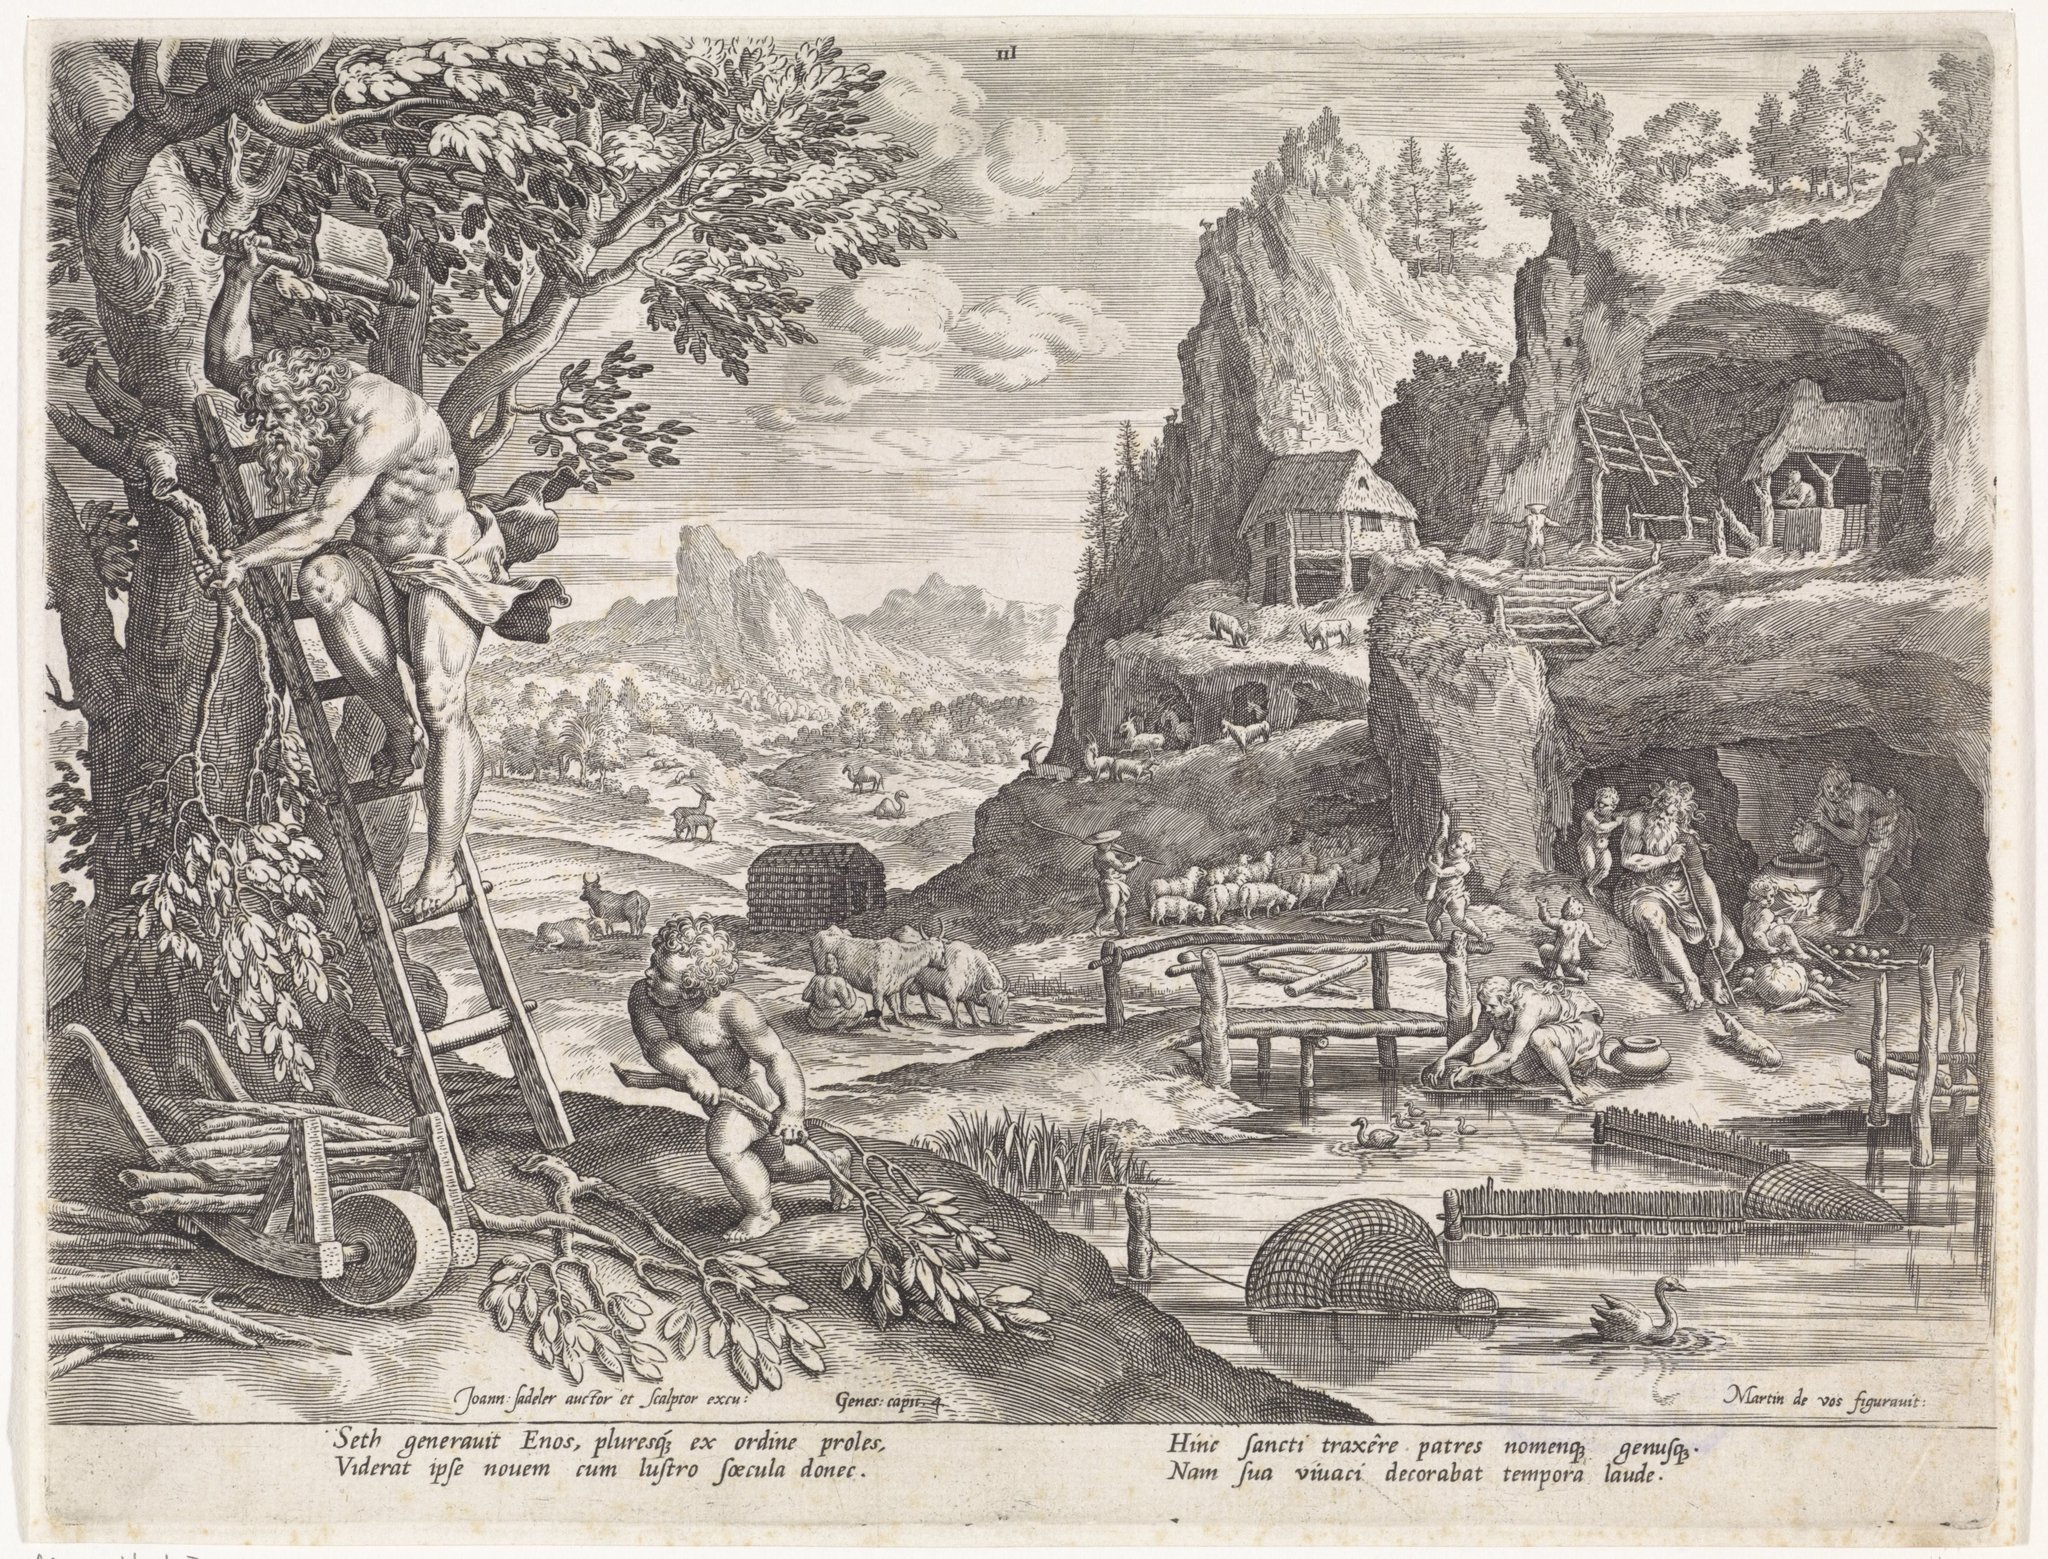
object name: print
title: Bonorum et Malorum consensio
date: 1586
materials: paper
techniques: engraving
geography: antwerp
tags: story of seth, story of enos, woodgathering, woodgatherer, woodcutting, woodcutter ~ forestry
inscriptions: collector's mark: Lugt 10, collector's mark: Lugt 11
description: Set en zijn zoontje Enos zijn bomen aan het snoeien en hout aan het verzamelen. Links maakt de vrouw van Set het eten klaar terwijl de rest van de familie de dieren verzorgt. De prent heeft een Latijns onderschrift.